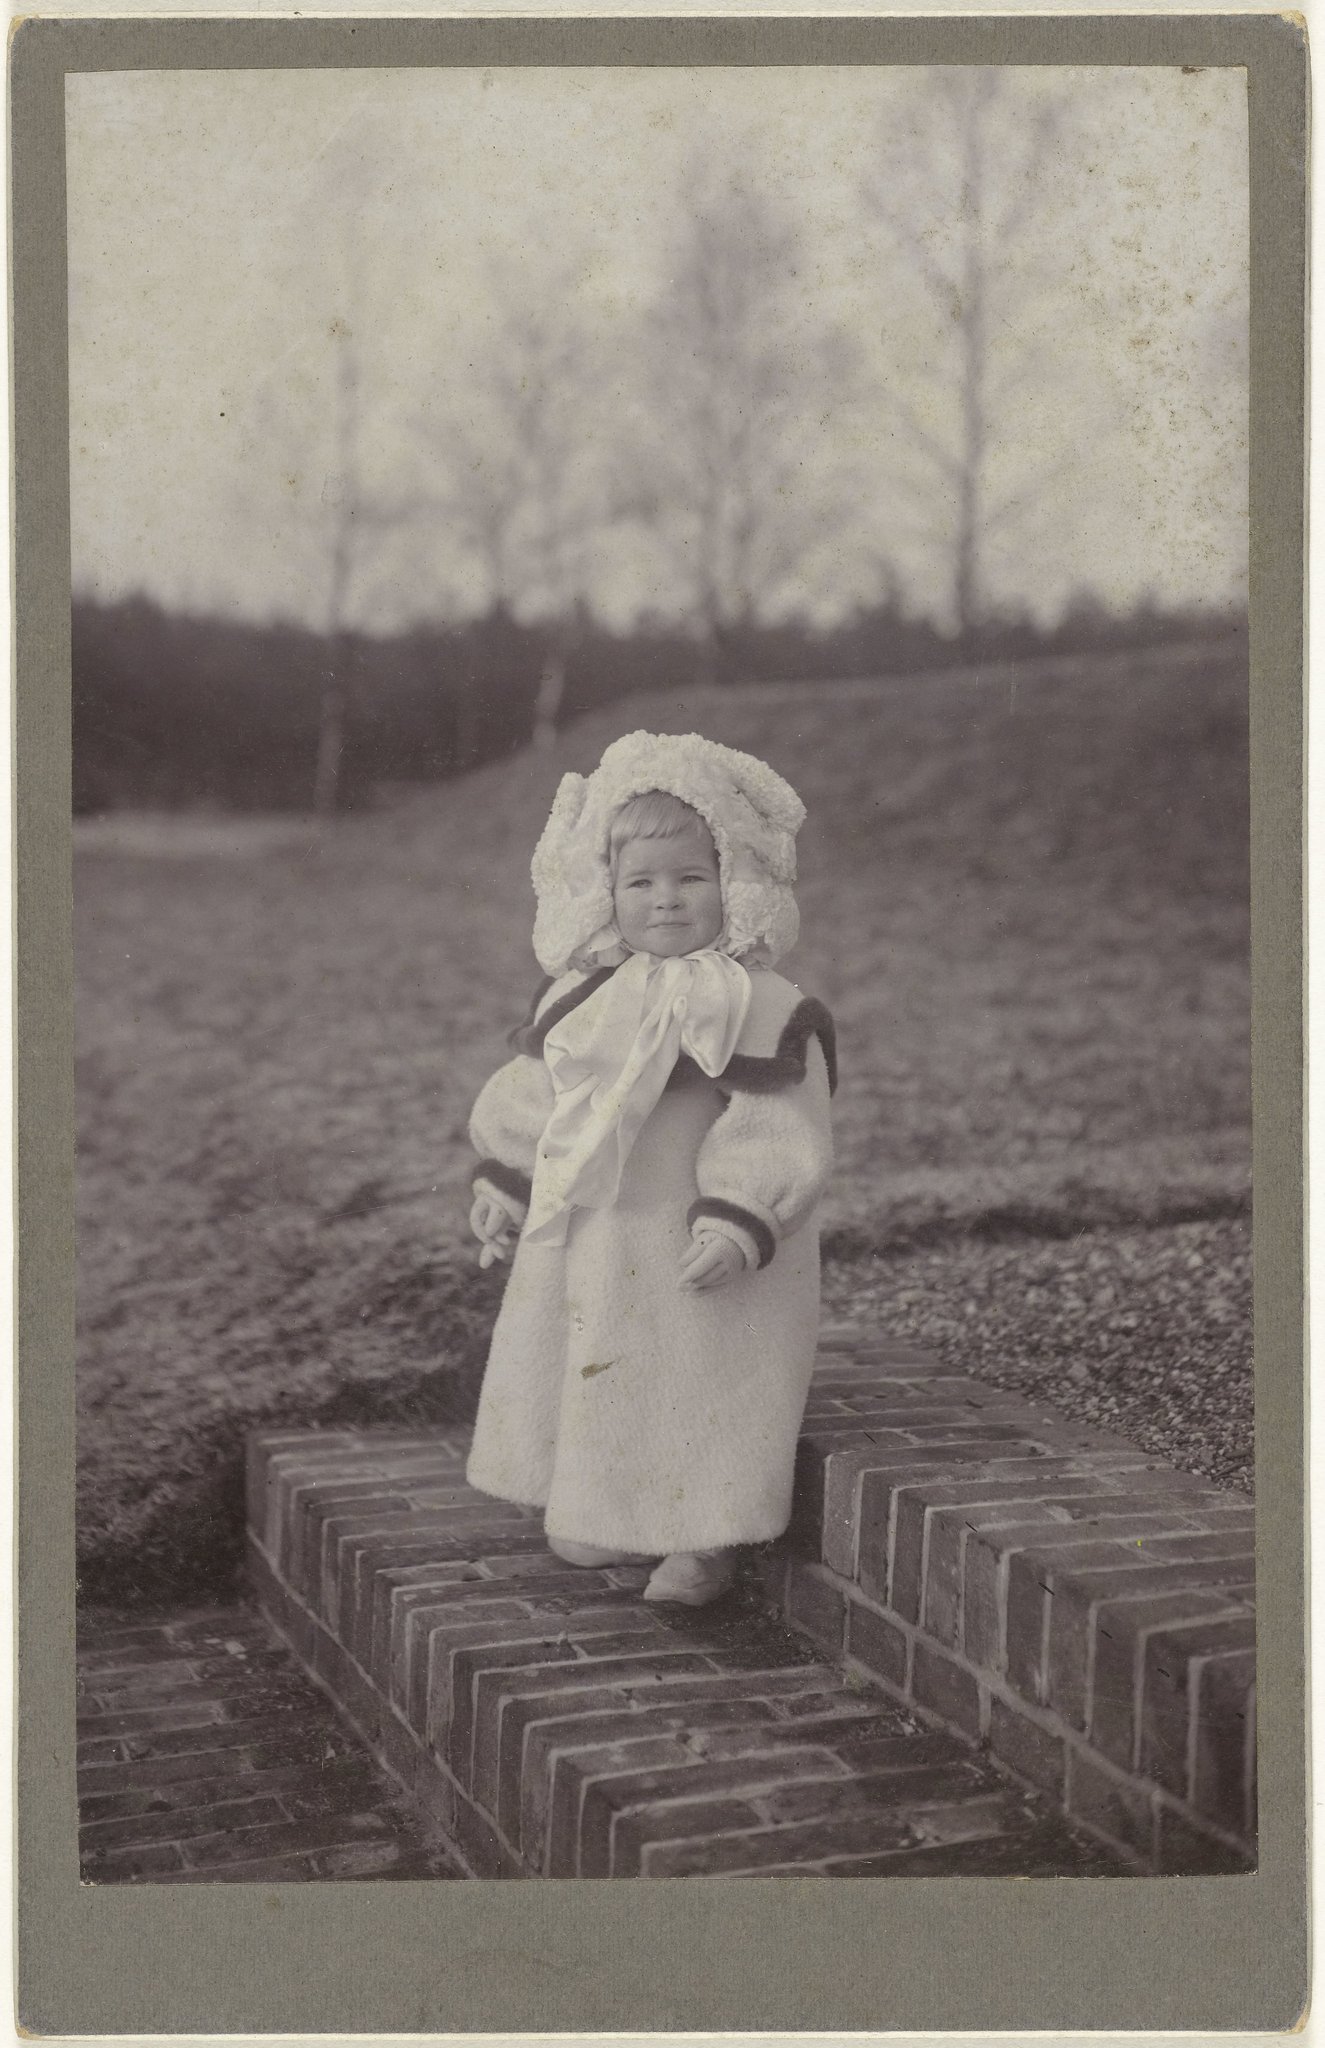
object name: photograph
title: Portret van Irène Pauw van Wieldrecht, een dochter van de fotograaf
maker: henry pauw van wieldrecht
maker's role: fotograaf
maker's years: 1863-1912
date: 1908-1910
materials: cardboard, photographic support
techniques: gelatin silver print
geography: netherlands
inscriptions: annotation: ‘Irène’